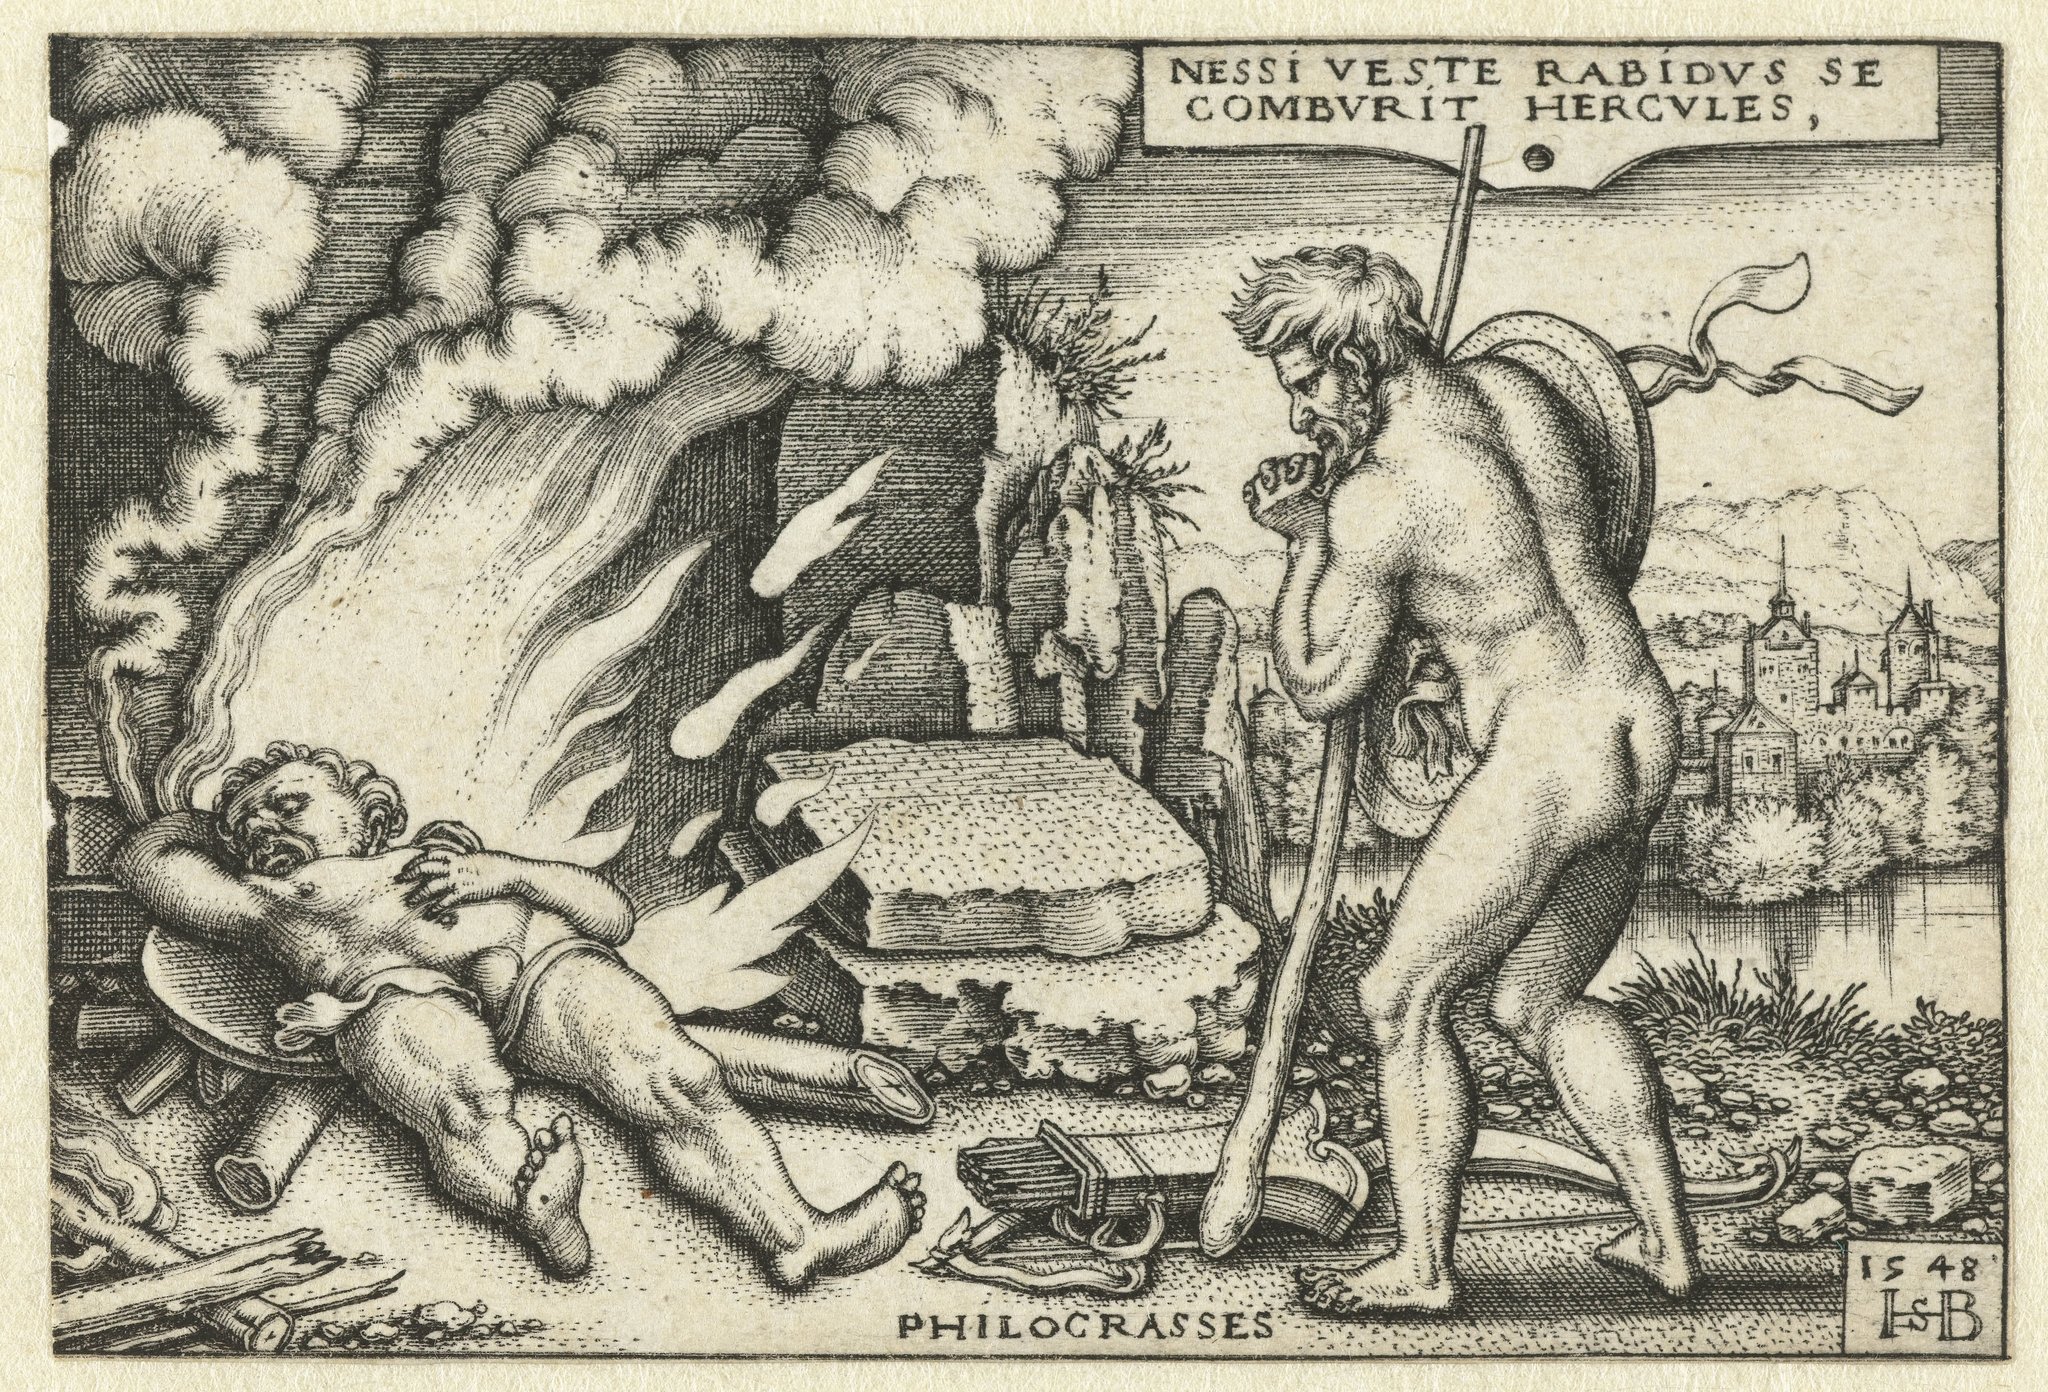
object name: print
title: Nessi veste rabidvs se combvrit Hercvles Philocrasses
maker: hans sebald beham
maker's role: designer, draughtsman, print maker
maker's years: 1500-1550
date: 1548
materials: paper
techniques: engraving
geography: frankfurt am main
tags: death of hercules, the pyre is lit: hercules gives his bow, arrows and quiver to philoctetes (or poeas)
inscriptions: collector's mark: ‘Hinloopen’ Lugt 11